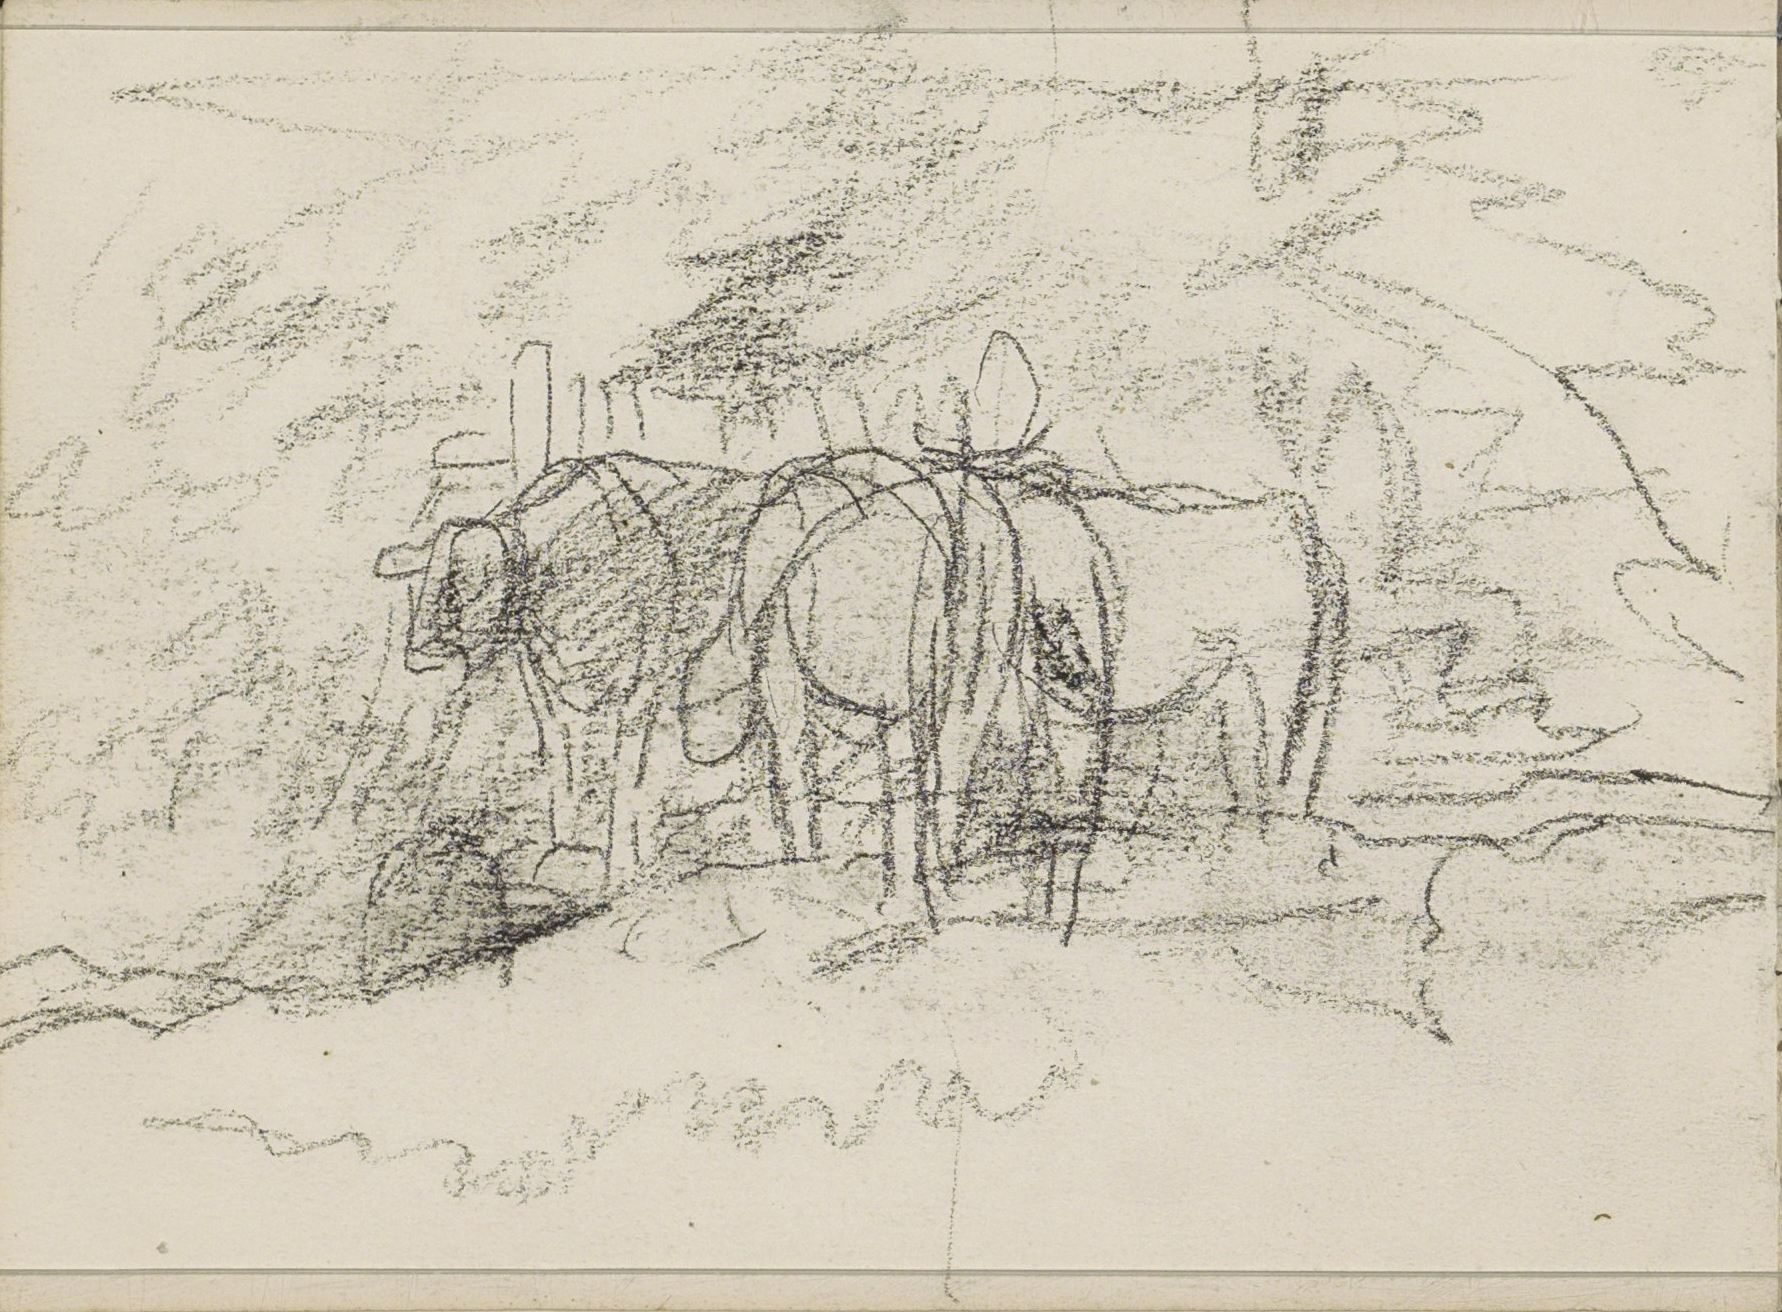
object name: sketchbook leaf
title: Koeien in een landschap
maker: anton mauve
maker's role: draughtsman, painter, print maker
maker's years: 1838-1888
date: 1848-1888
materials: chalk, paper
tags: cow, meadow, pasture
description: Blad 17 verso uit een schetsboek met 33 bladen.